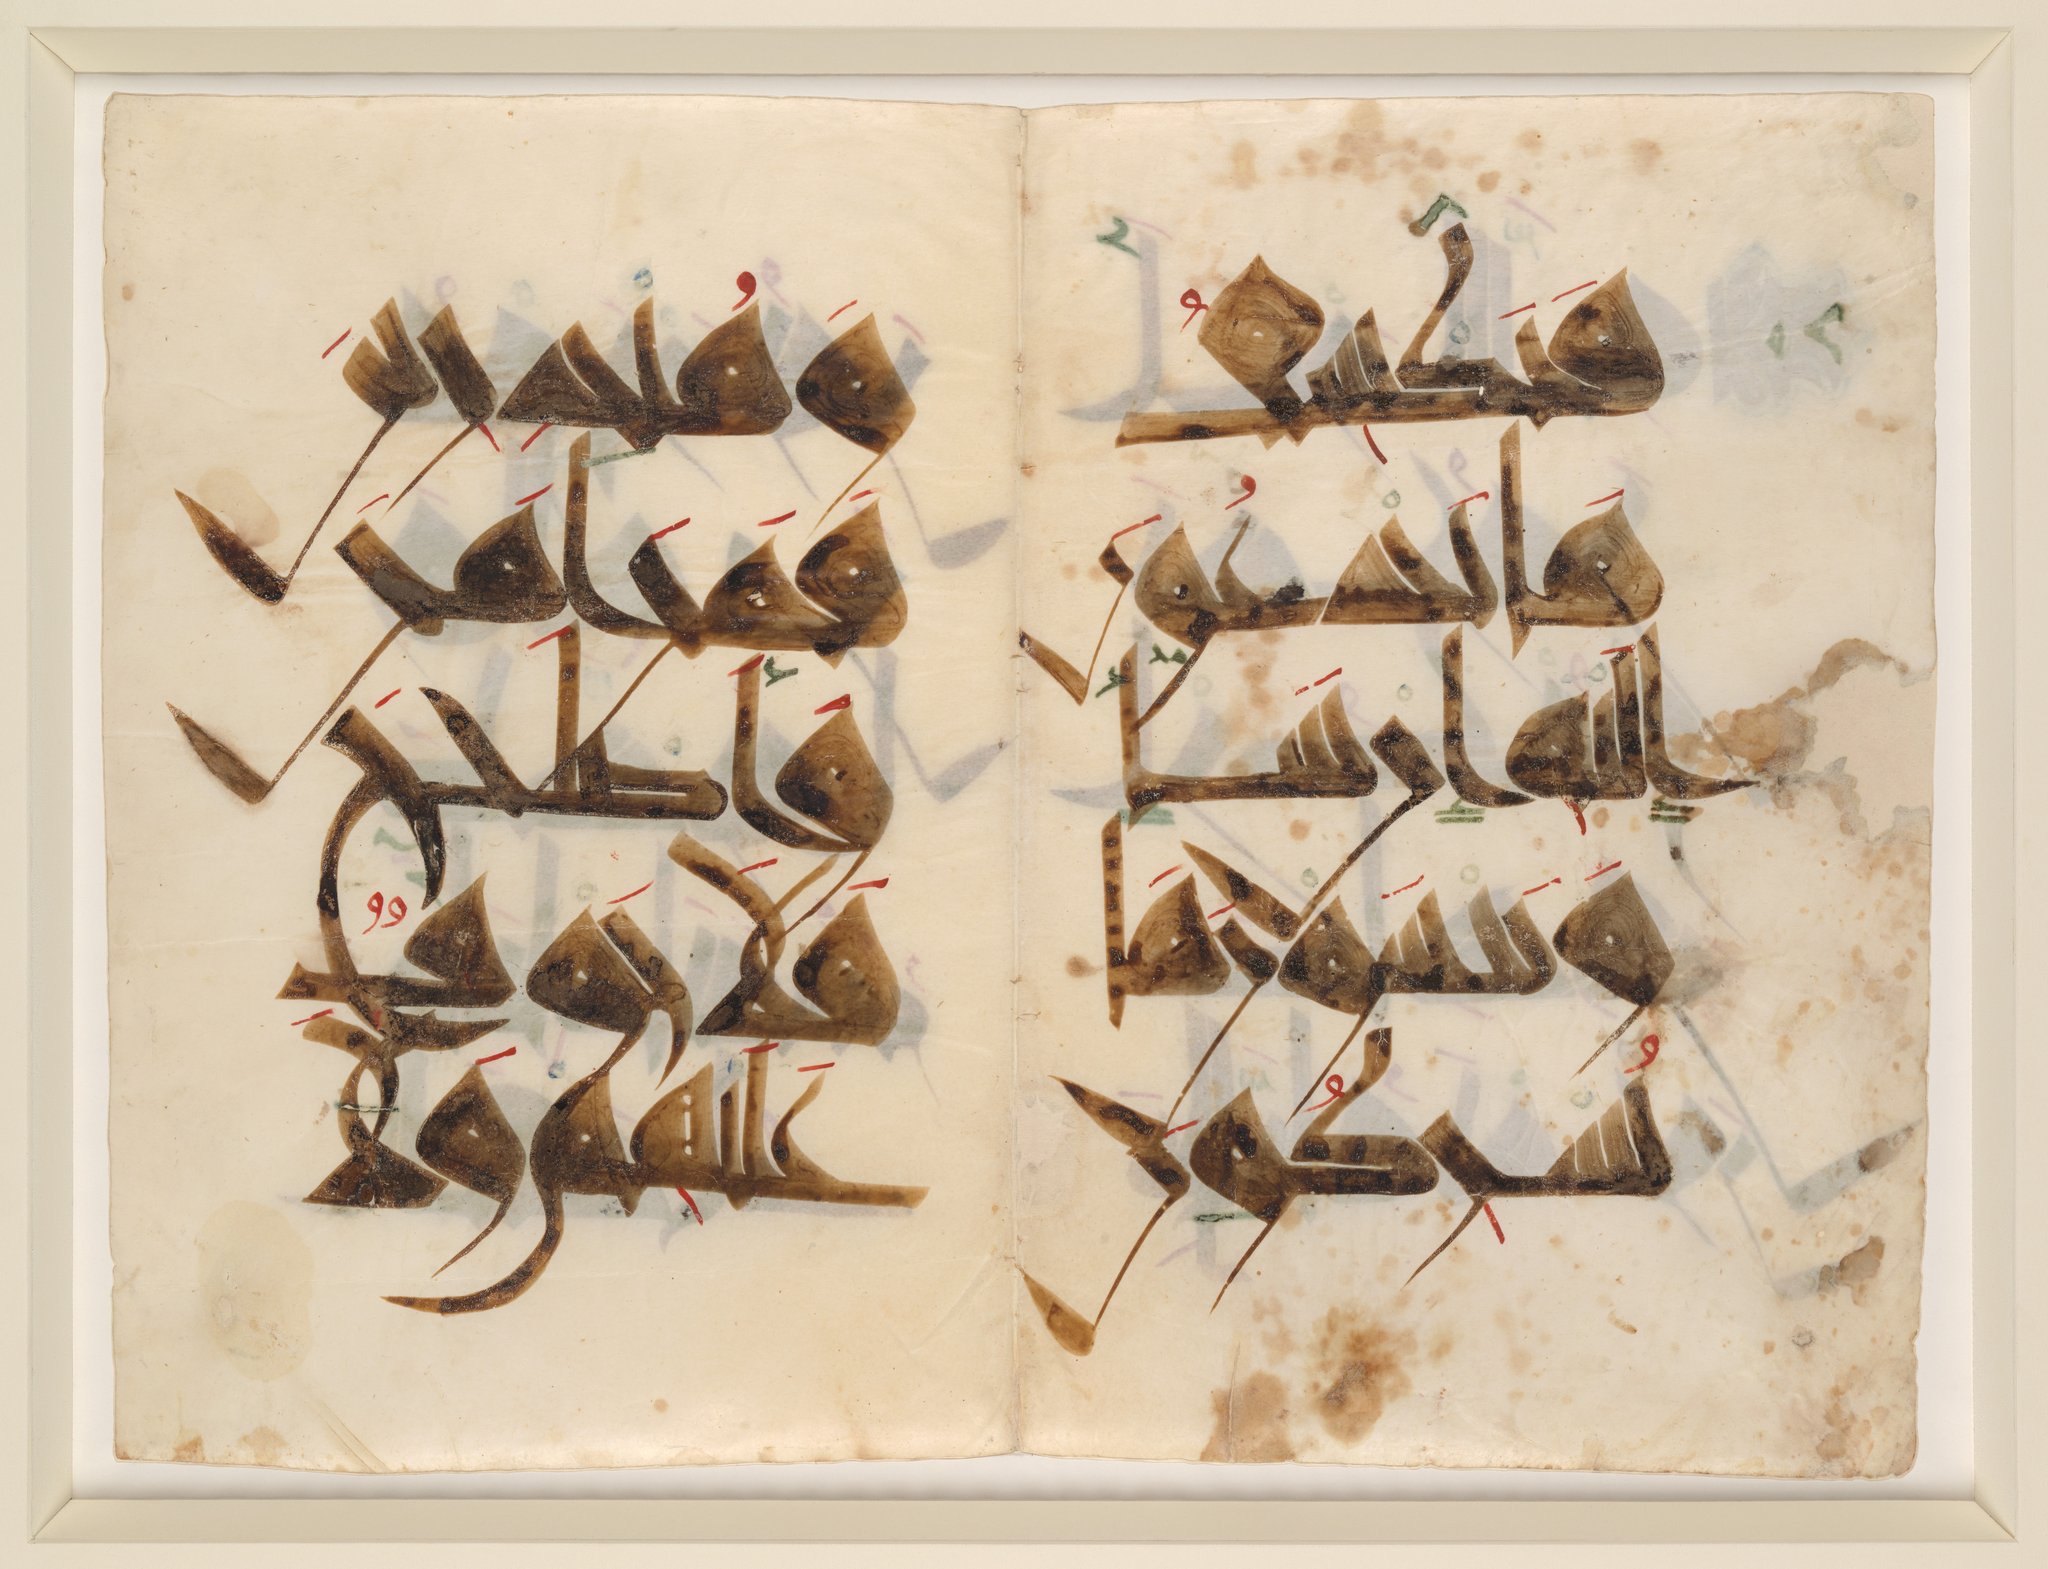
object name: folio from an illustrated manuscript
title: Bifolium from the "Nurse's Qur'an" (Mushaf al-Hadina)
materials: gold, ink, parchment, watercolor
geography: tunisia